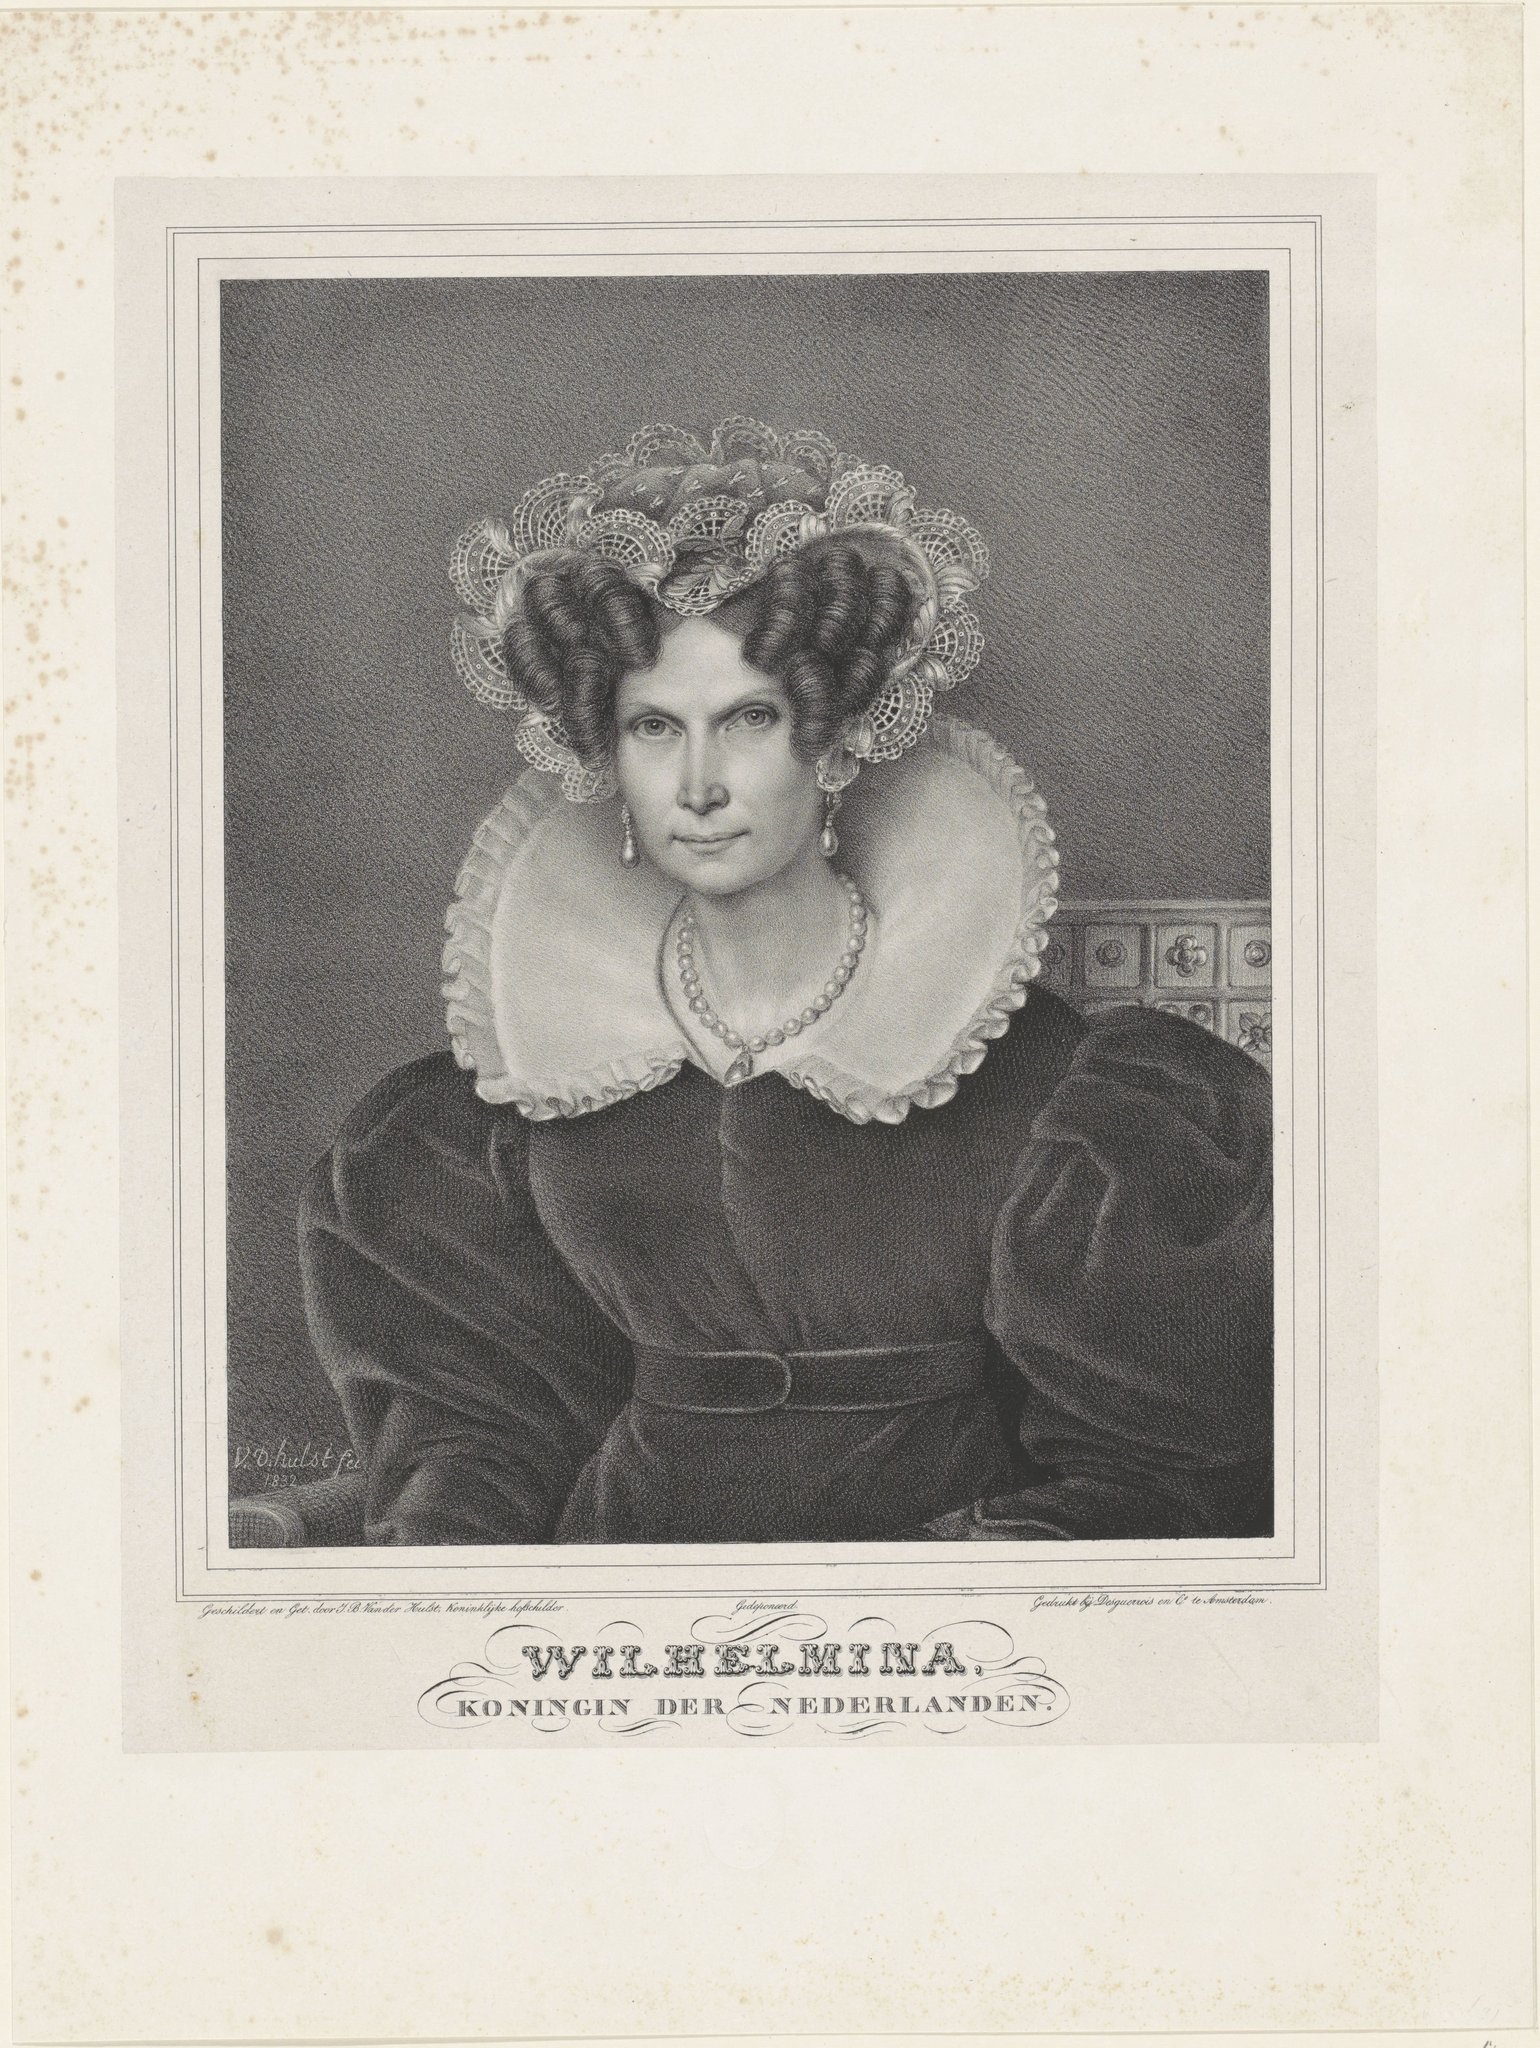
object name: print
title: Portret van Wilhelmina van Pruisen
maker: jean-baptiste van der hulst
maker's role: draughtsman, painter, print maker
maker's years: 1790-1862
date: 1832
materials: paper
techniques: lithograph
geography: netherlands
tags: berlin, the hague, wilhelmina frederica louisa (koningin der nederlanden)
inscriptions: check stamp: ‘... HOF LEVERANCIER’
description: Portret van Wilhelmina. In de ondermarge haar naam en titel.